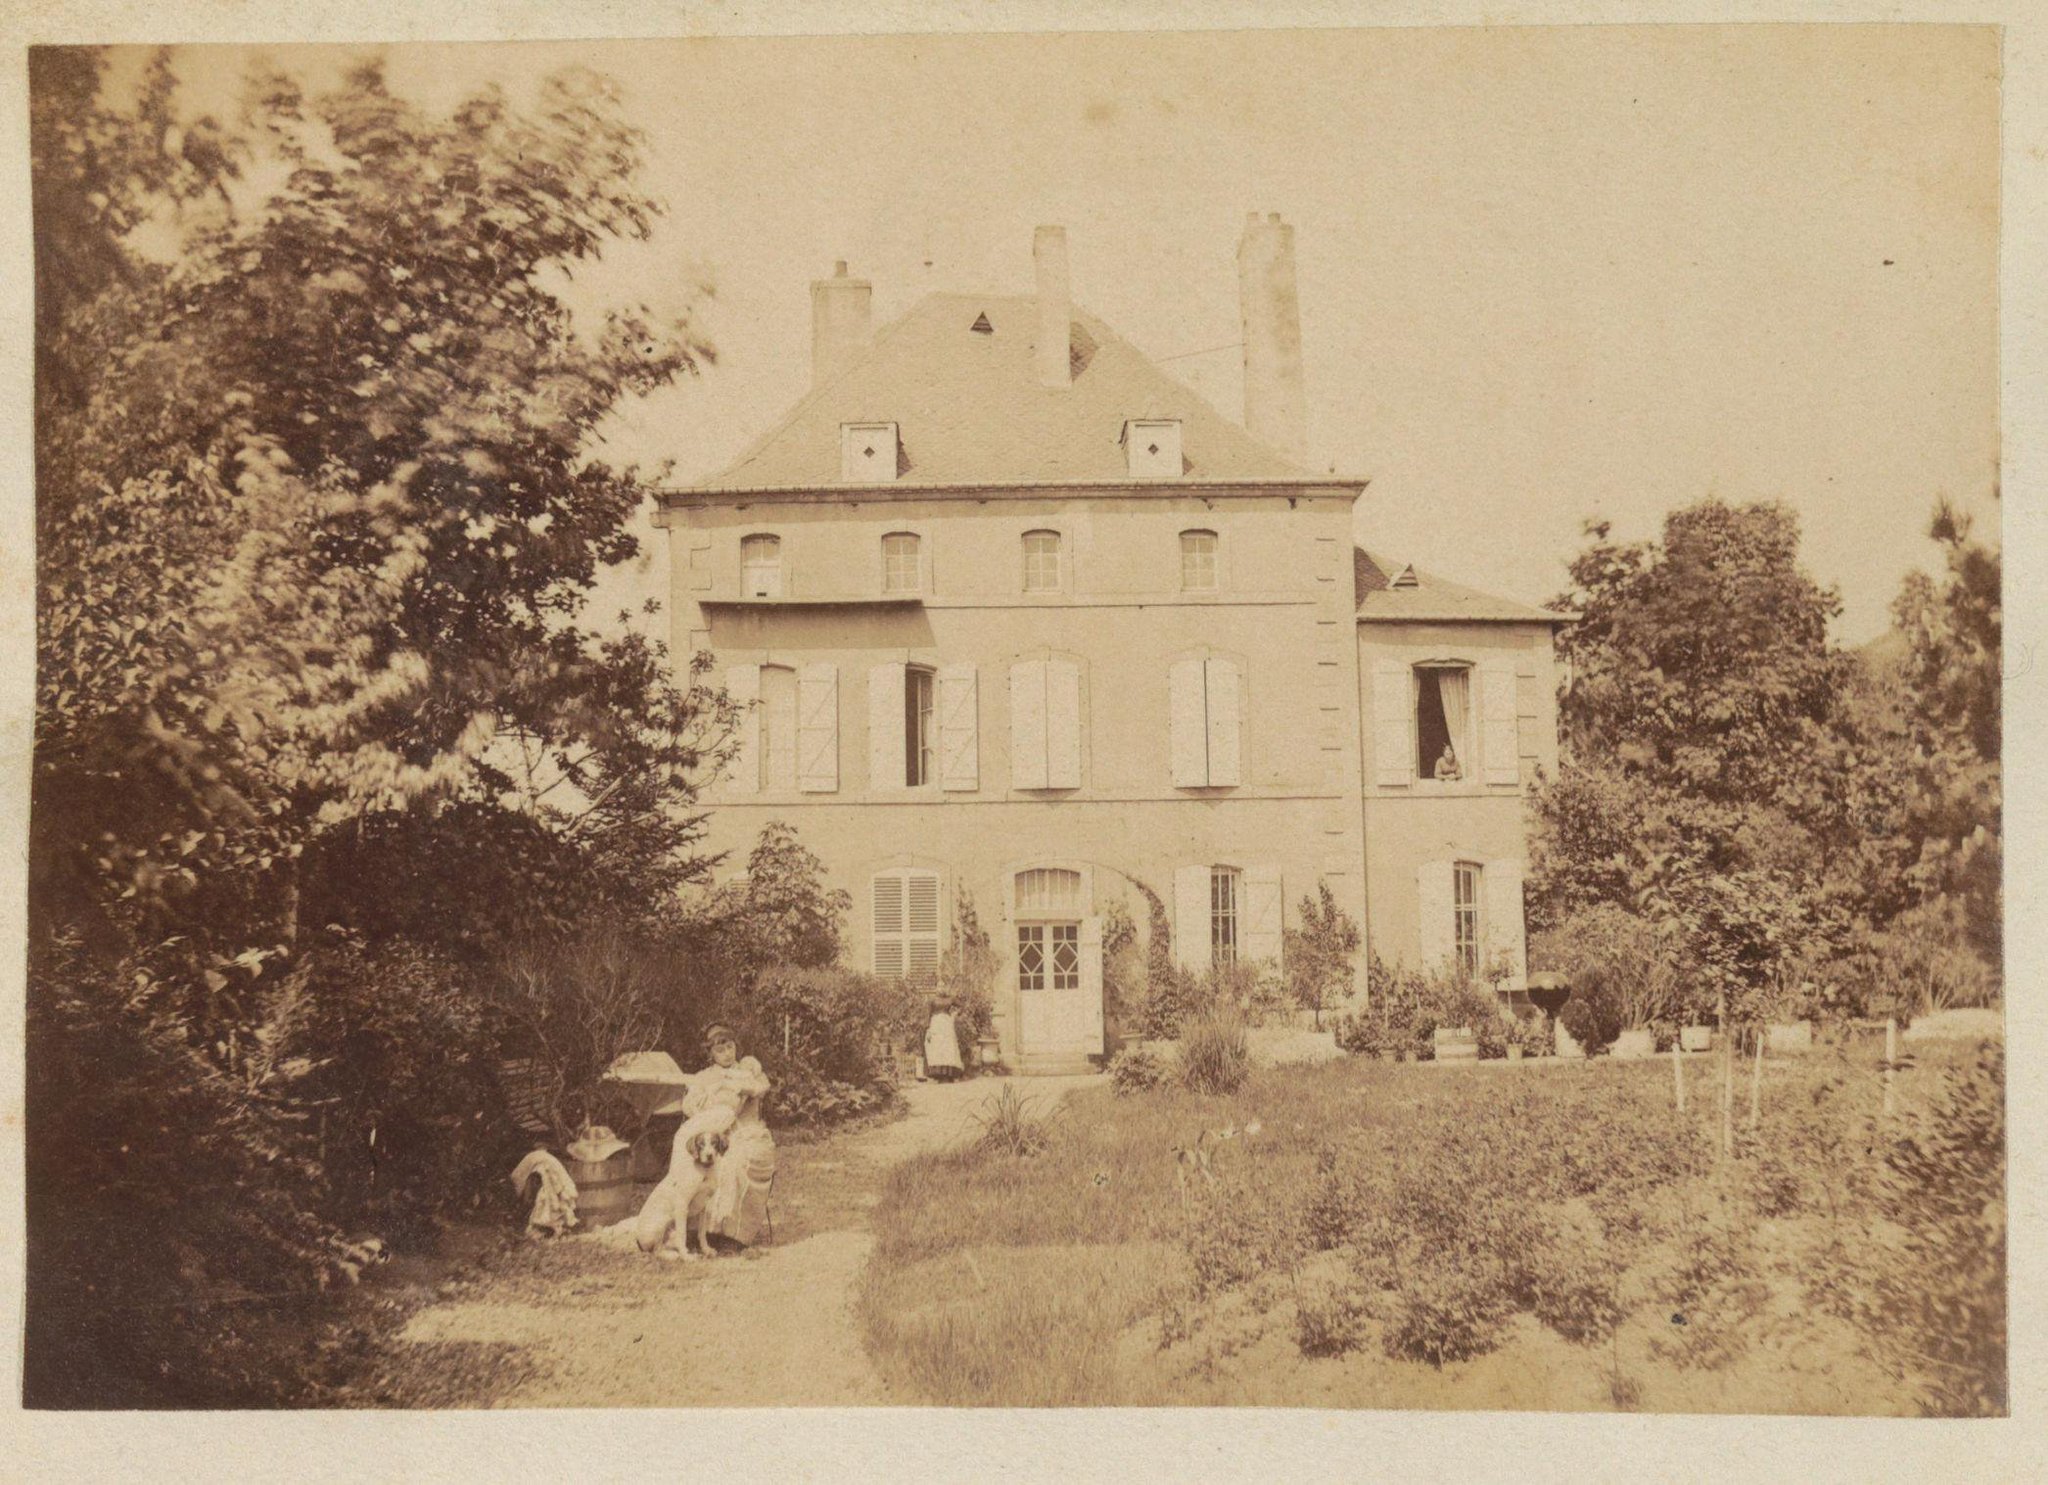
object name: photograph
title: Vrouw met baby zittend in de tuin van een landhuis in Frankrijk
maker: Anonymous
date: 1805-1884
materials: photographic support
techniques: albumen print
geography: france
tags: rural housing, e.g. country-house, villa, cottage, mother and baby or young child, france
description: Onderdeel van Album van een Franse amateurfotograaf met opnames van familie, militairen, industrie, landschappen en bezienswaardigheden in Frankrijk.